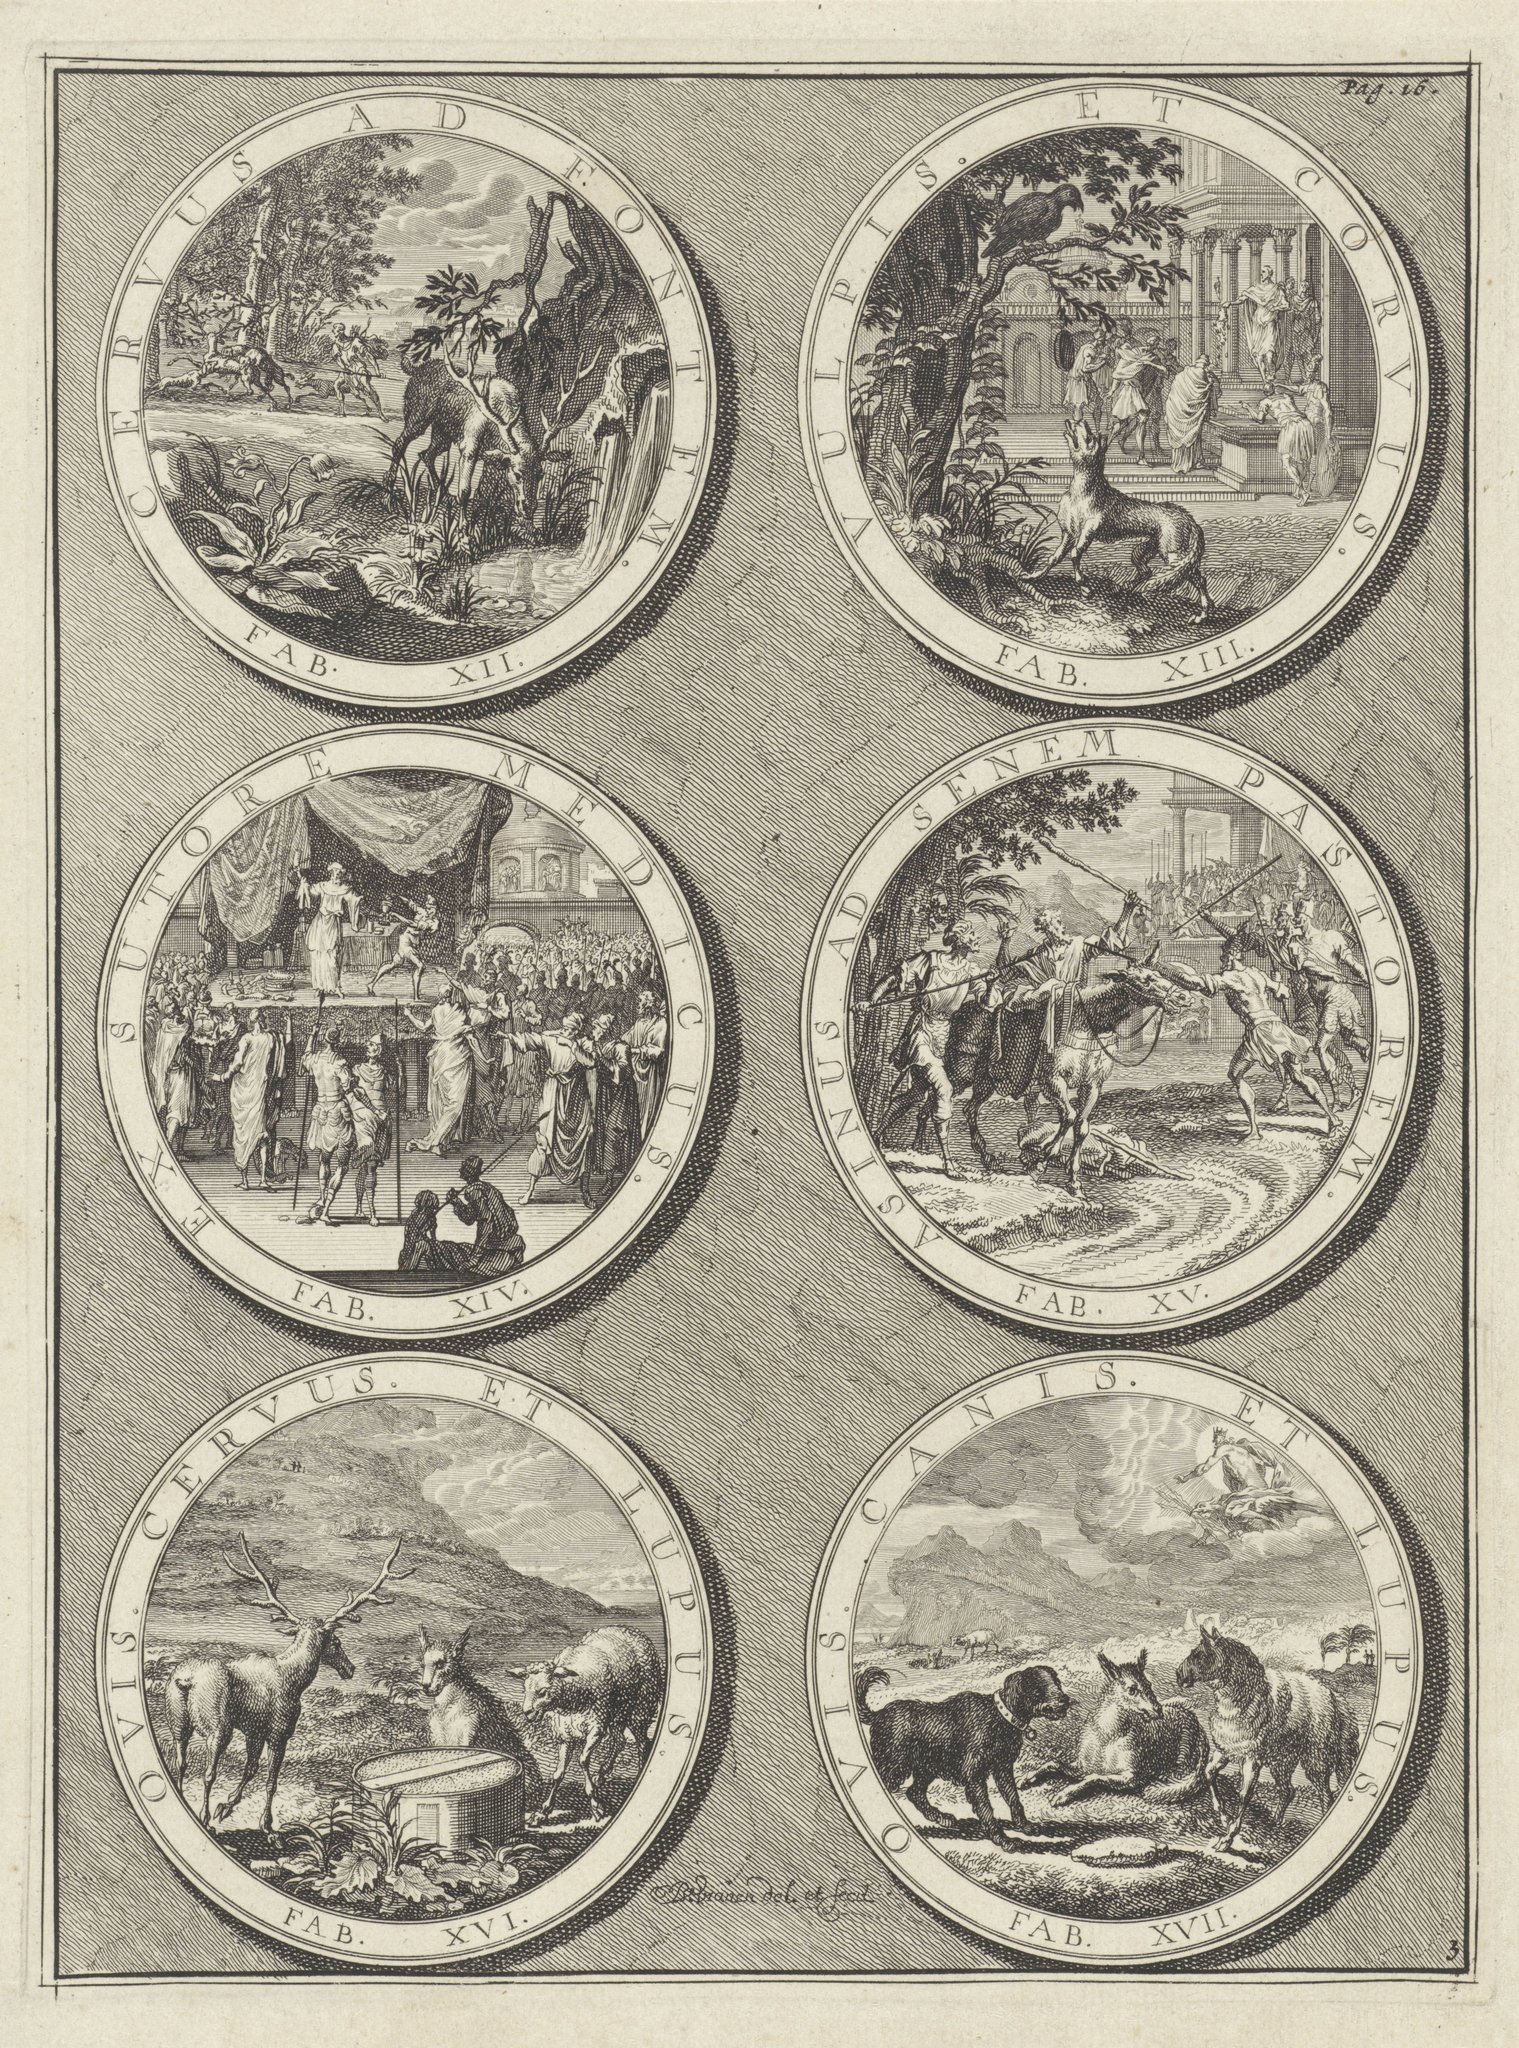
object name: book illustration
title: Zes medaillons met fabels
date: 1701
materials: paper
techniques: engraving, etching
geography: amsterdam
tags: fables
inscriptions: collector's mark: Lugt 2228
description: Zes medaillons met fabels; fabel XII het hert bij de fontein, fabel XIII de vos en de raaf, fabel XIV de schoenmaker die zich uitgeeft voor arts, fabel XV de ezel en zijn herder, fabel XVI het hert en het schaap, fabel XVII het schaap, de hond en de wolf. Rechtsboven: Pag. 16. Rechtsonder: 3.